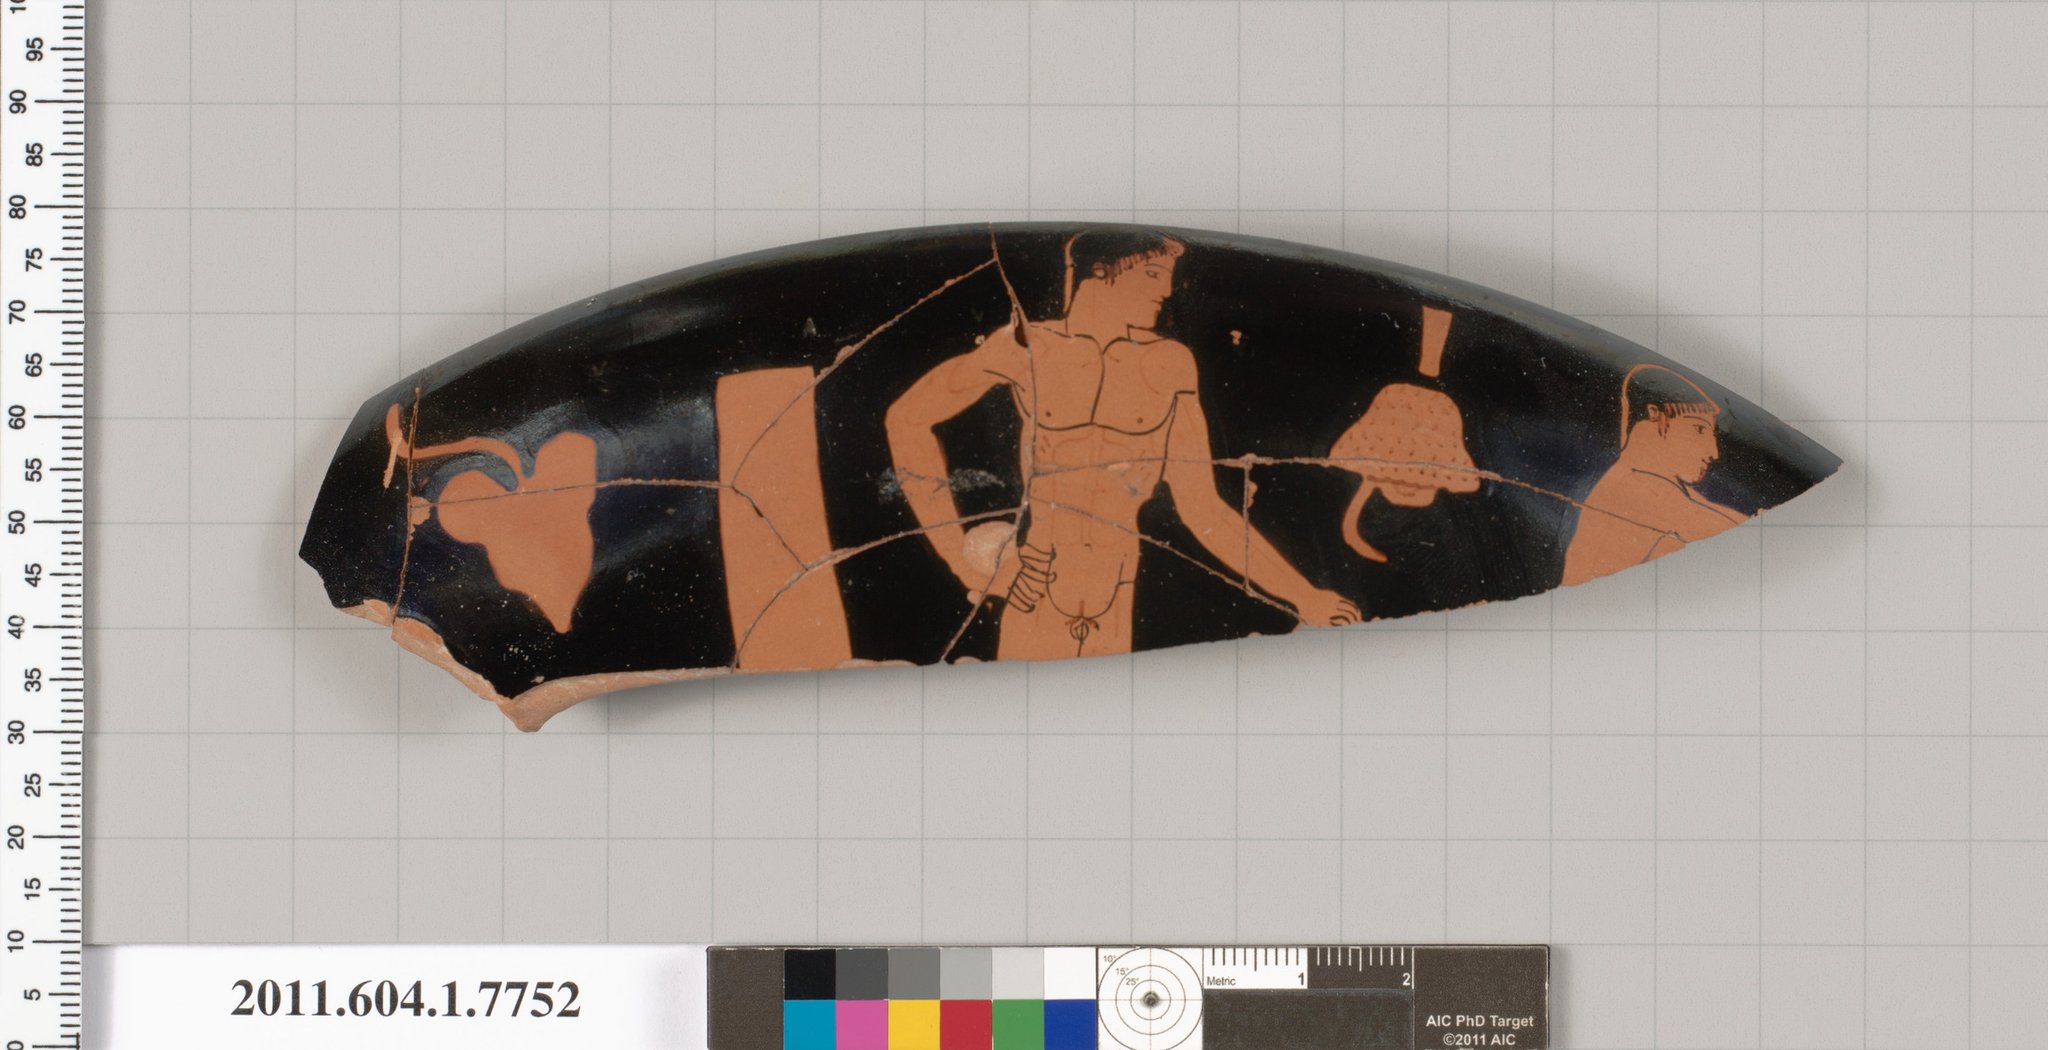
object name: kylix fragment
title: Terracotta rim fragment of a kylix (drinking cup)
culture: greek, attic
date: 460-450 BCE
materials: terracotta